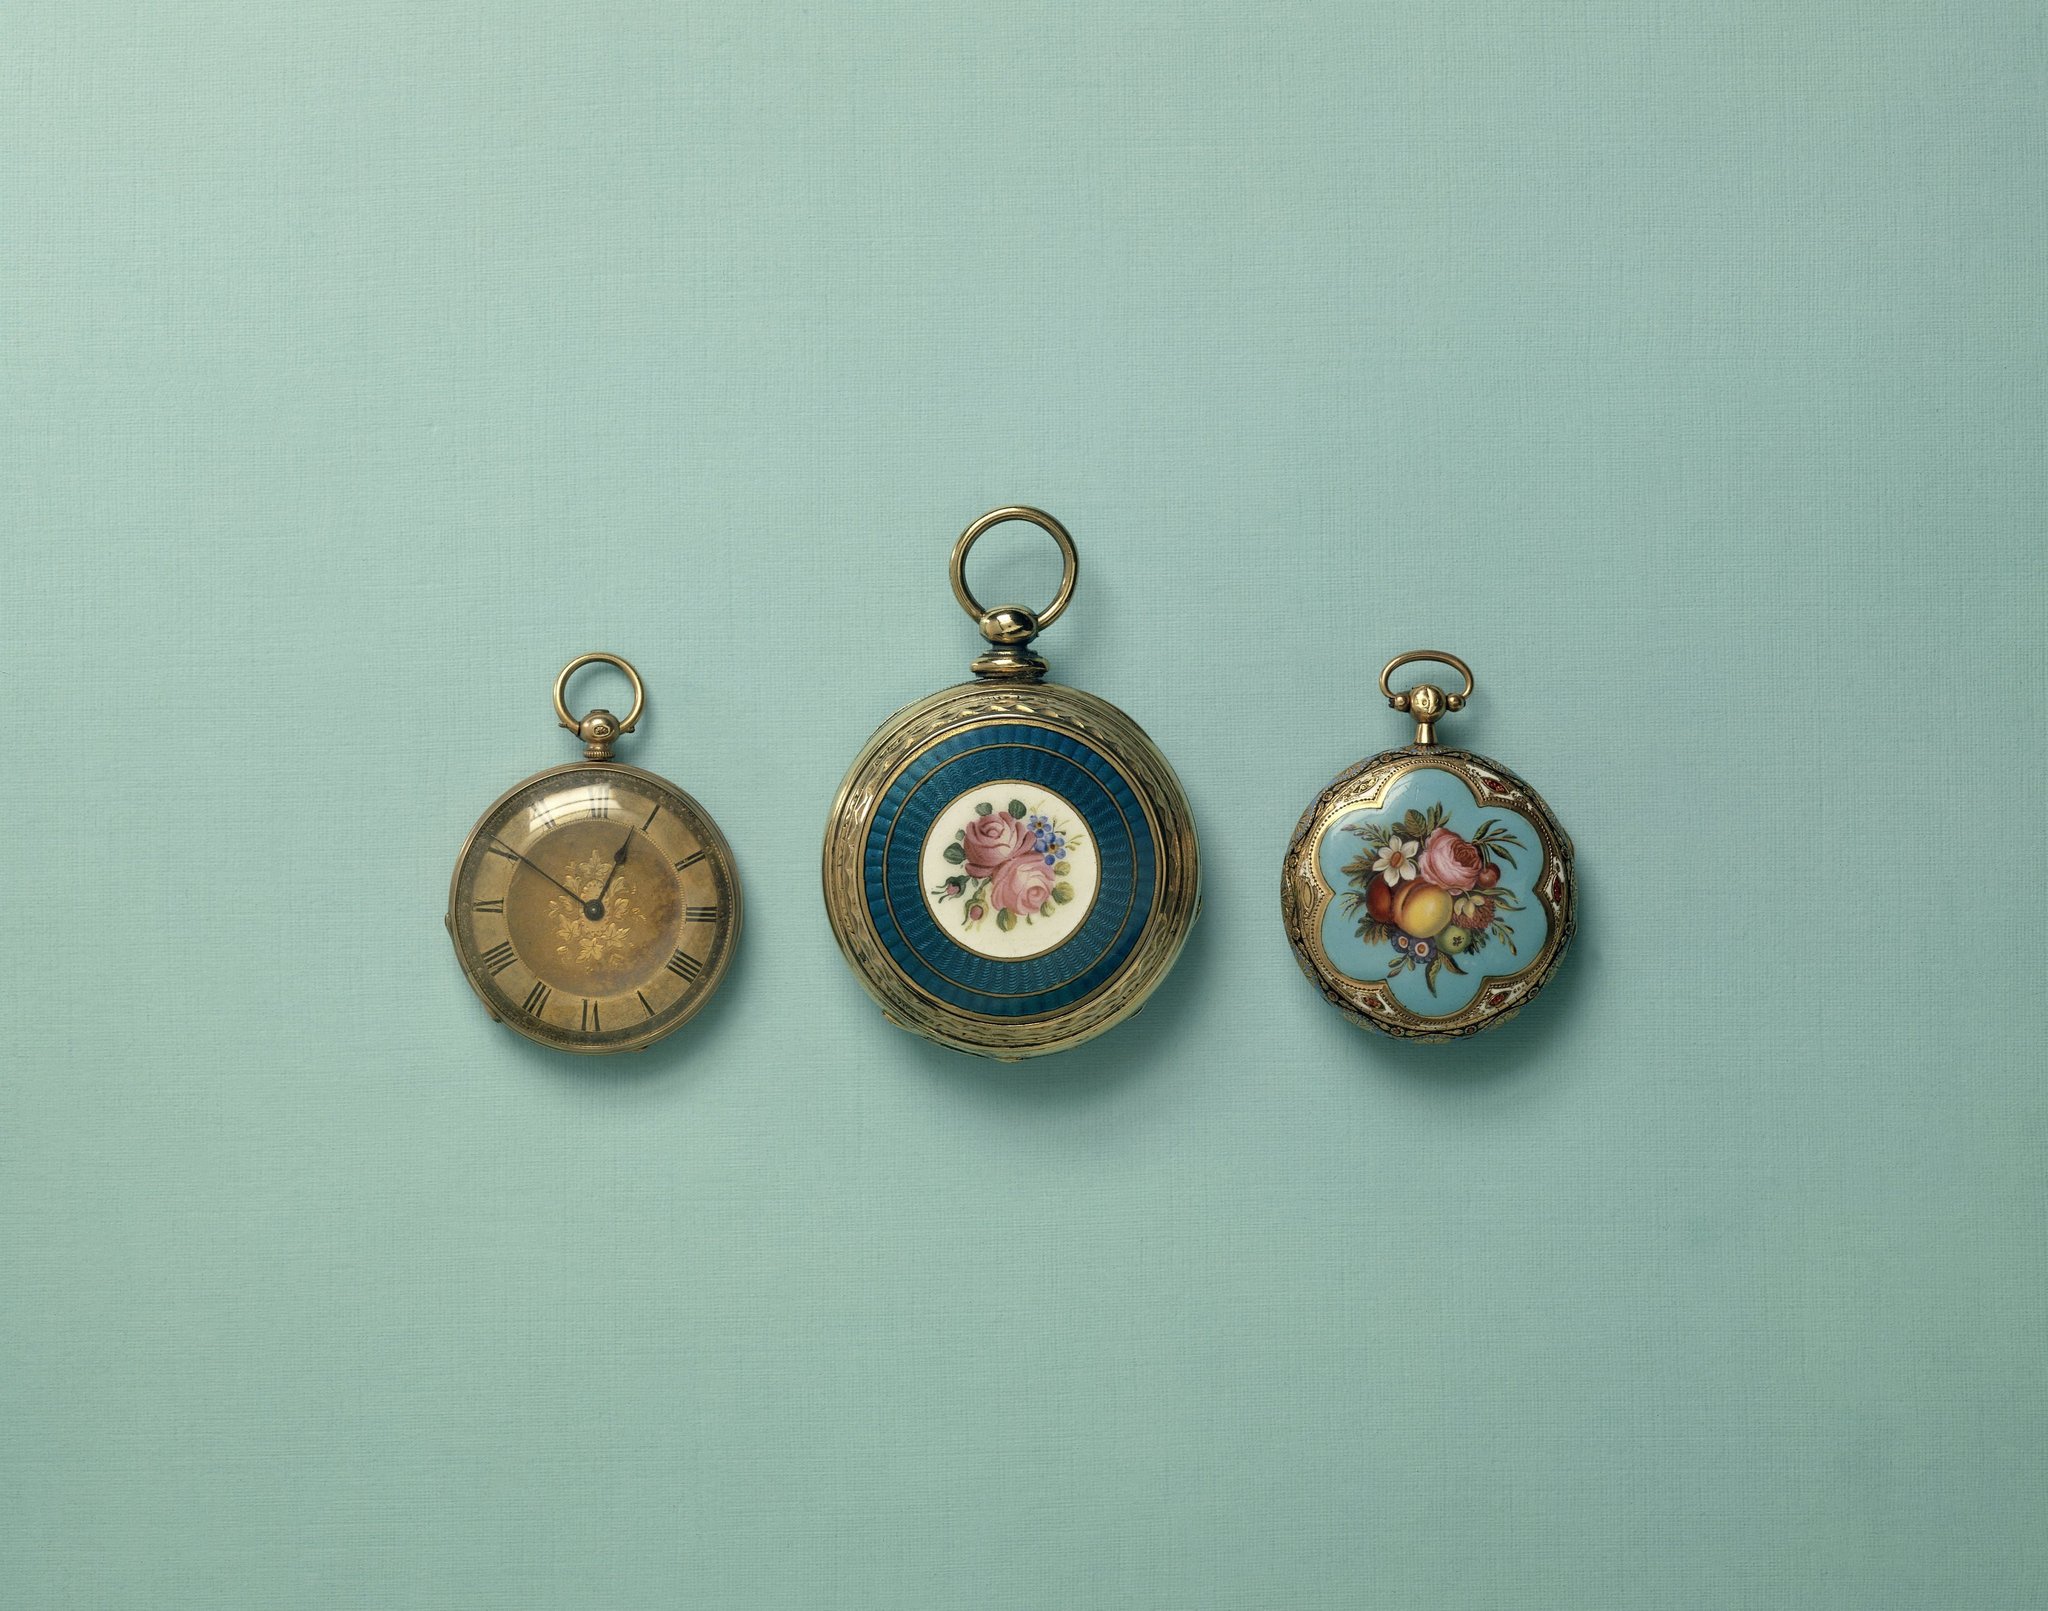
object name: jewellery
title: Horloge van goud met gegraveerde gouden wijzerplaat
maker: Anonymous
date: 1850-1900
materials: gold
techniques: engraving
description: Horloge van goud met gegraveerde gouden wijzerplaat. Achterbodem van de kast met graveerwerk versierd, waartussen email.